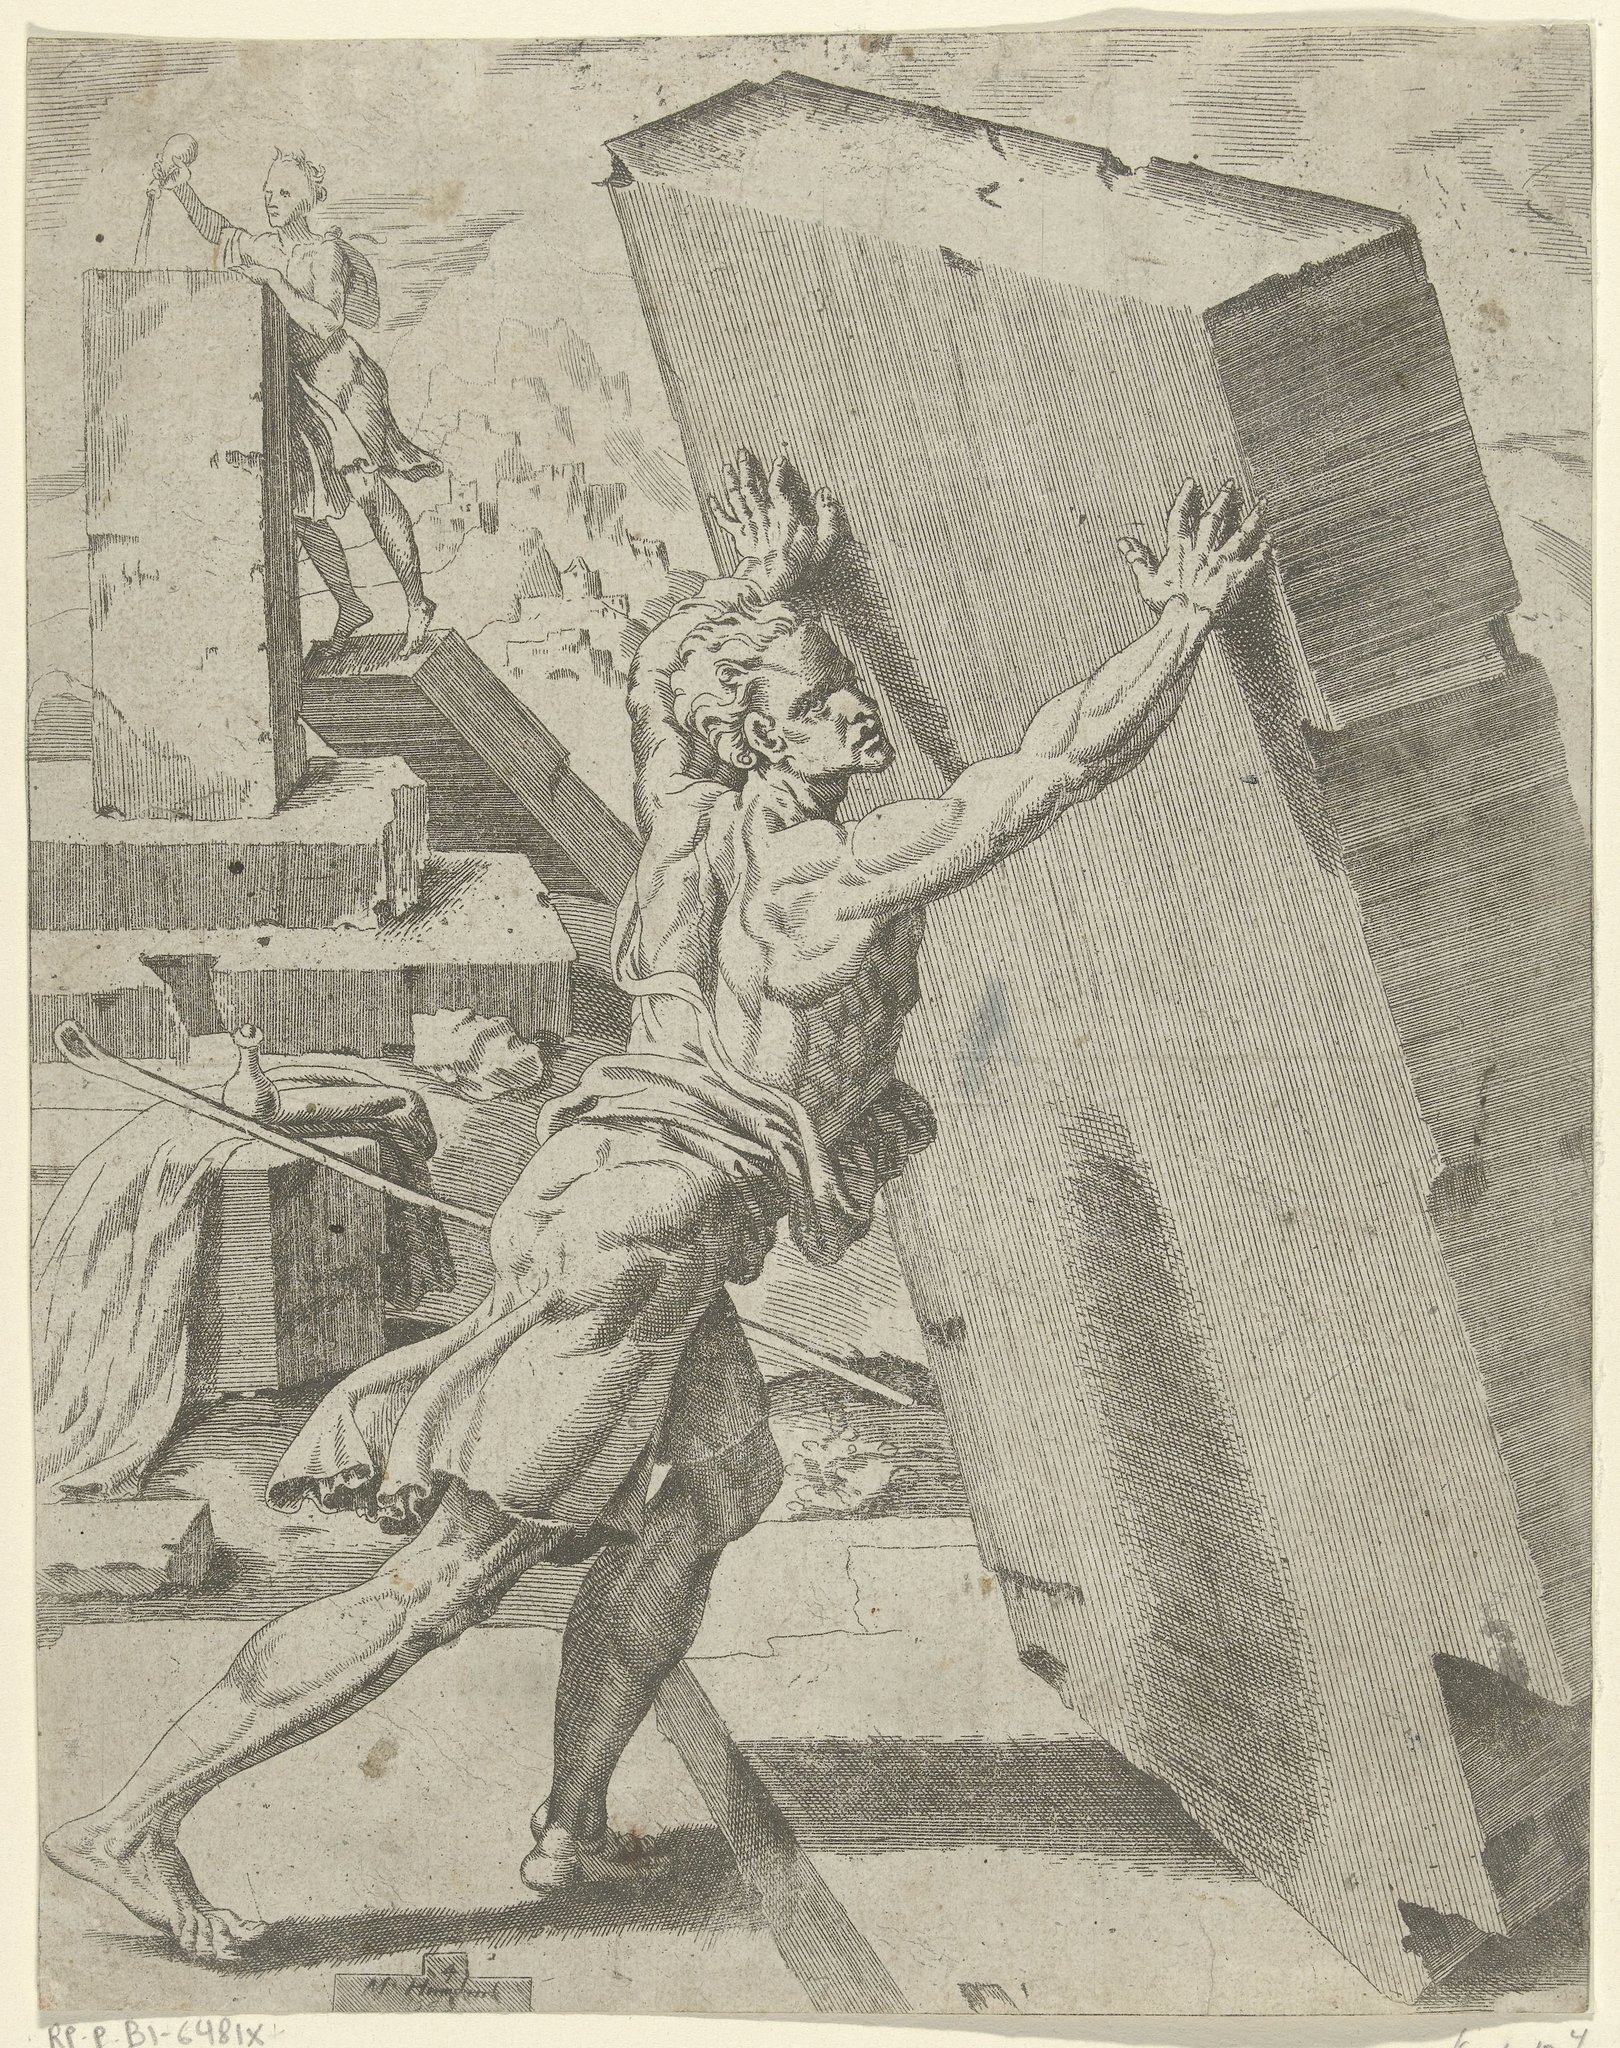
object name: print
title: Geschiedenis van Jakob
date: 1549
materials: paper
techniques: etching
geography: haarlem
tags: jacob awakes, anoints the stone and names the place bethel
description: Jakob richt een steen op. Op de achtergrond begiet hij de steen met olie noemt de plaats Betel, huis van God. De prent maakt deel uit van een serie over de geschiedenis van Jakob.